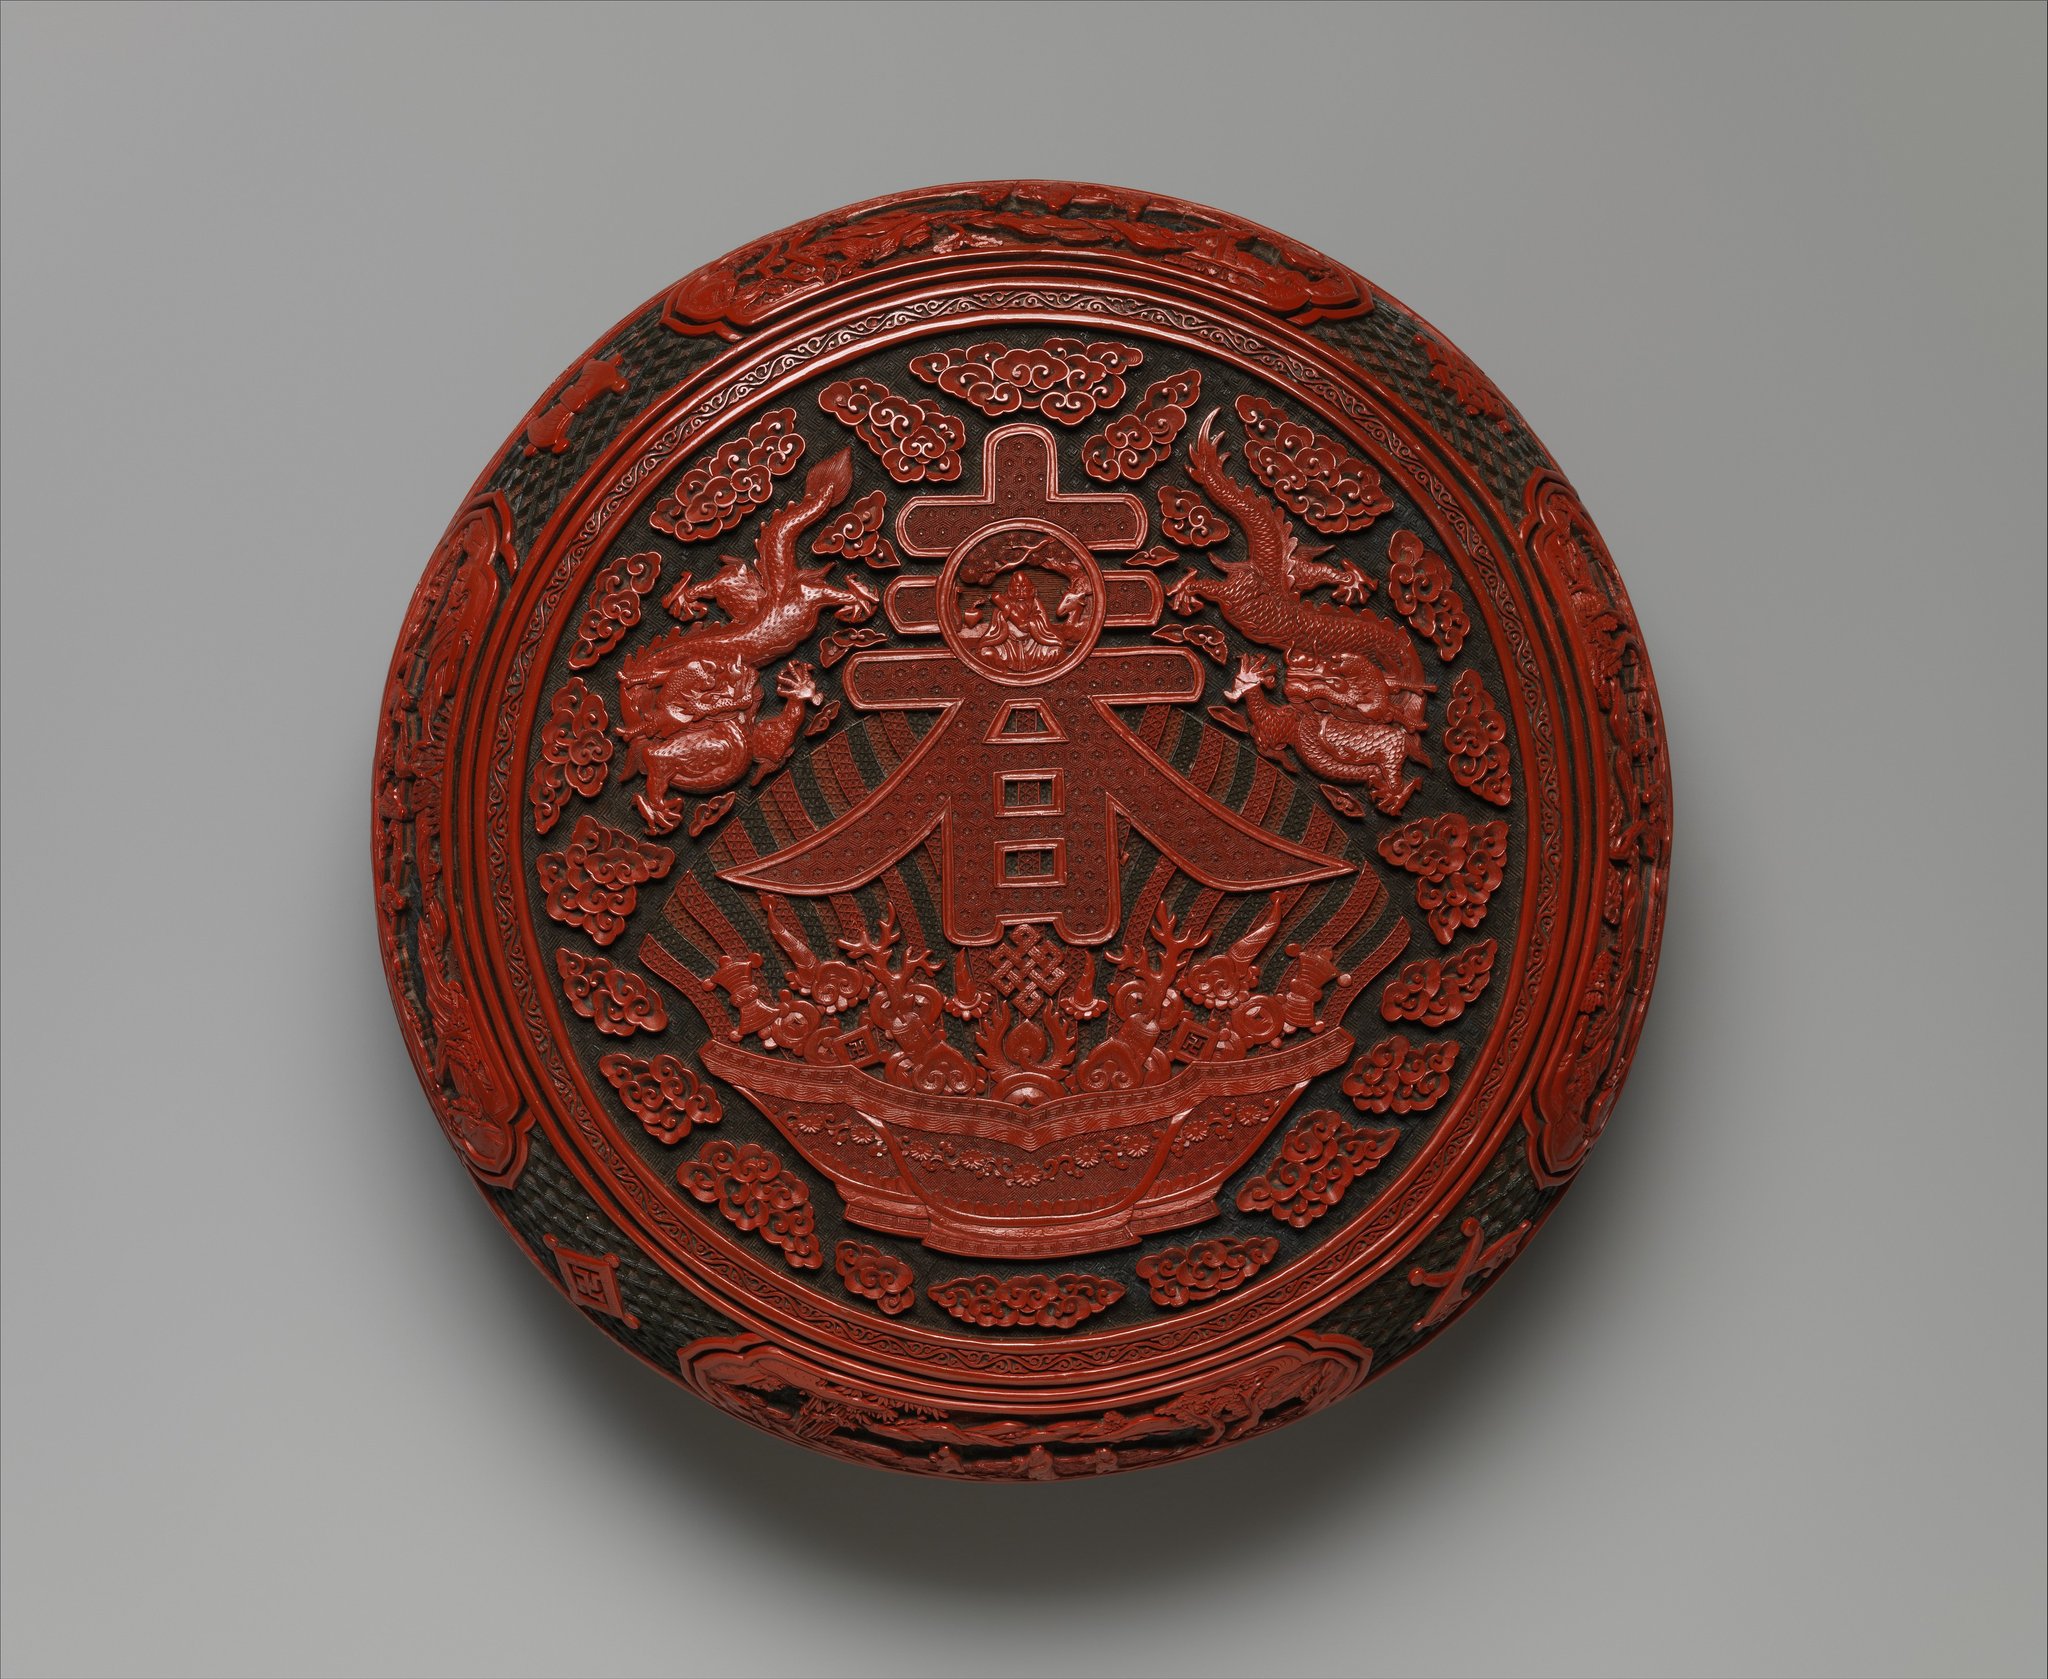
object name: box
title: Precious Spring Longevity Box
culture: chinese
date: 1736-1795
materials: lacquer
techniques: carving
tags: dragons